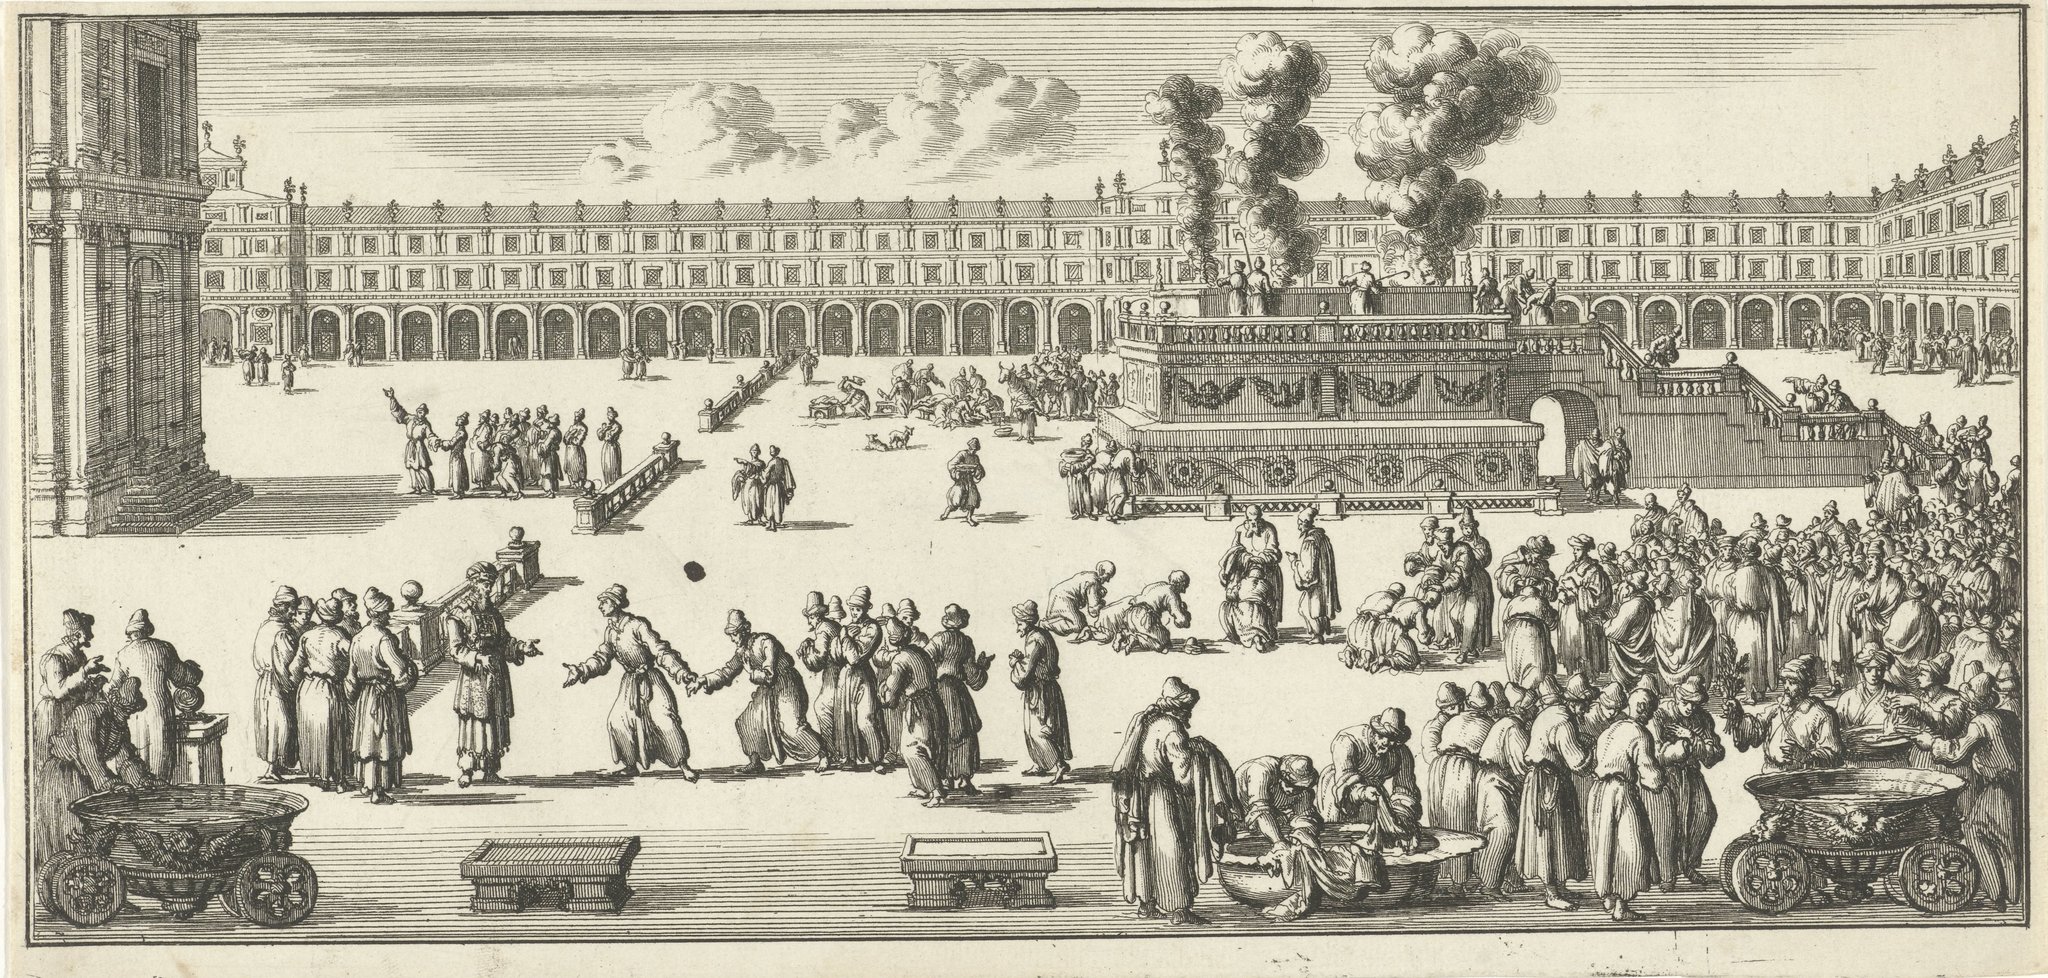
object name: print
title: Wijding van de Levieten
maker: jan luyken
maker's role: draughtsman, print maker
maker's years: 1649-1712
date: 1683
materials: paper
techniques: etching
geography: amsterdam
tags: the levites are appointed to serve the priests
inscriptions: collector's mark: Lugt 2233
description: Latere staat opgenomen in: Cunaeus, Petrus. De republyk der Hebreen, of gemeenebest der joden, 3 delen. Amsterdam: Wilhelmus Goeree, 1683, dl. 3, p. 76.